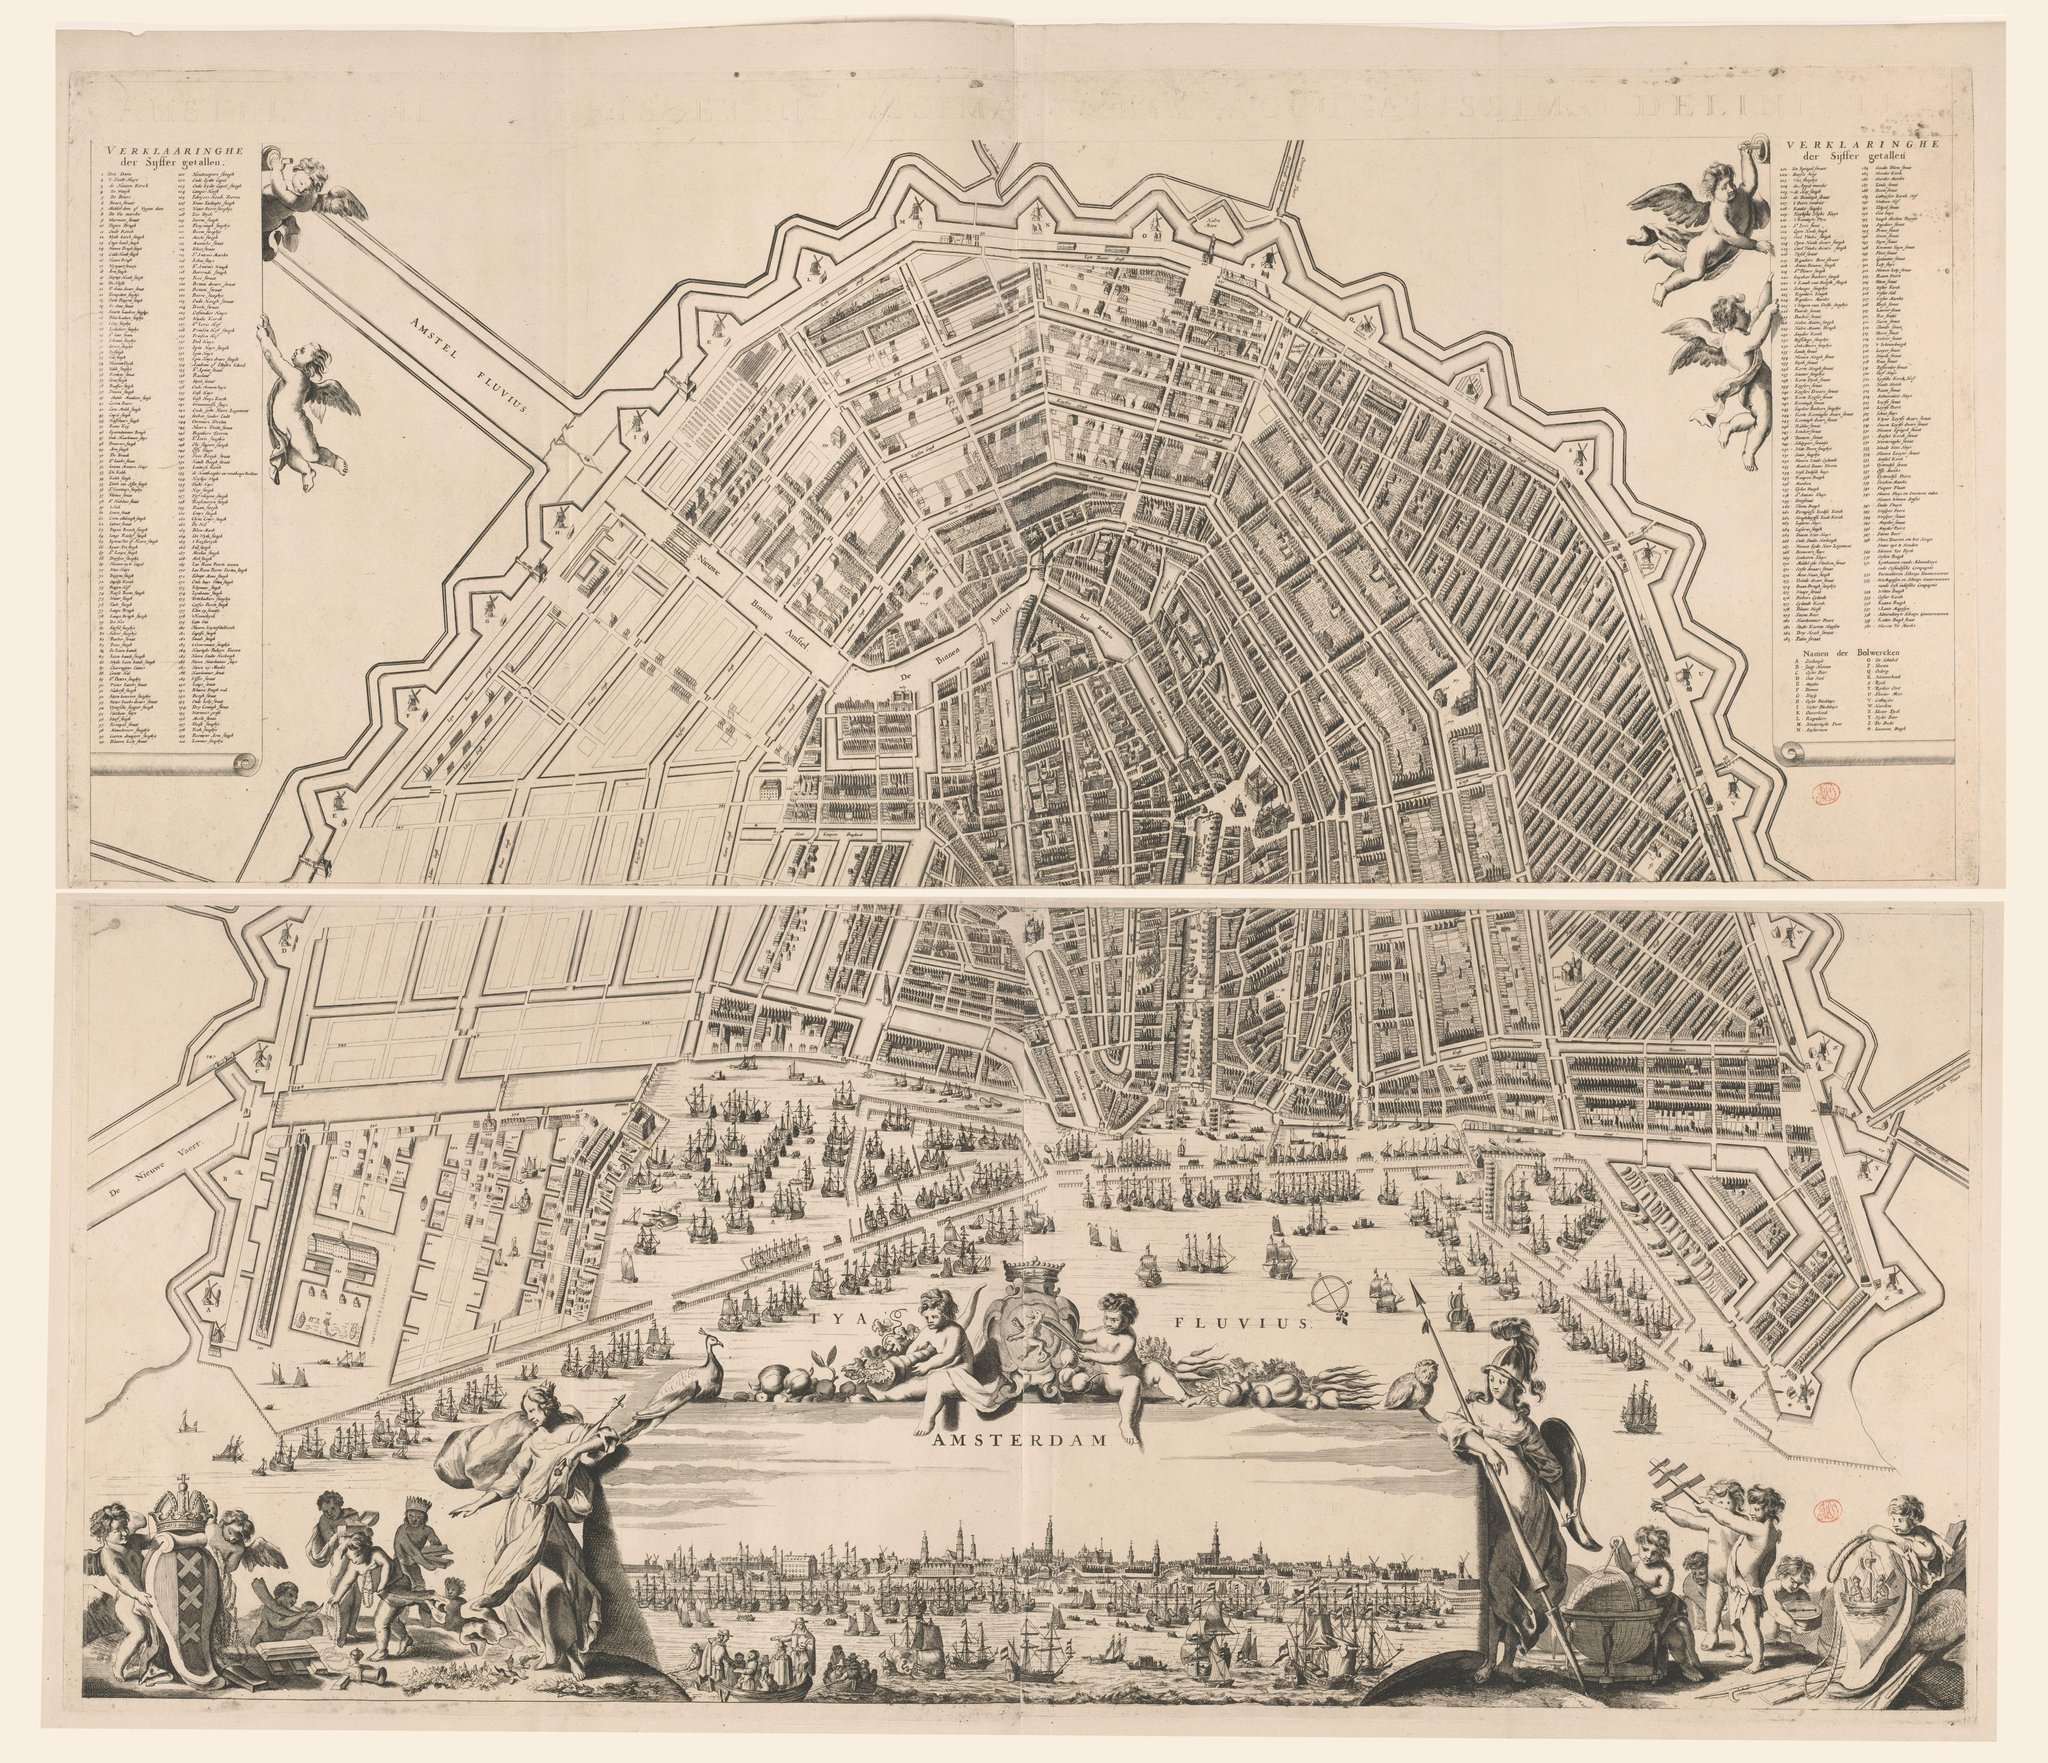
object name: print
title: Plattegrond van Amsterdam met stadsgezicht, bestaande uit twee delen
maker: Anonymous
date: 1676-1699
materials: paper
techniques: engraving, etching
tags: coat of arms (as symbol of the state, etc.) (+ city; municipal), (story of) juno (hera), (story of) minerva (pallas, athena), seal (as symbol of the state, etc.) (+ city; municipal), attributes of minerva: owl, globe, maps of cities, continents represented allegorically, trade, commerce and finance, position-finding at sea; nautical instruments, coat of arms (as symbol of the state, etc.) (+ province; provincial), prospect of city, town panorama, silhouette of city, amsterdam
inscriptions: collector's mark: Lugt 2228, collector's mark: Lugt 195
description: Plattegrond in vogelvluchtperspectief. Linksboven de legenda 1-200. Rechtsboven de legenda 201-360 en de legenda van de bolwerken A-Z. Linksonder putti met het wapen van de stad en kinderen met rijkdommen uit verschillende werelddelen. Onder in het midden een gezicht op de stad geflankeerd door Juno (links) en Minerva (rechts). Boven dit gezicht twee kinderen met het wapen van Holland. Rechtsonder kinderen met het stadszegel en voorwerpen die verwijzen naar de zeevaart. Oriëntatie: zuidzuidwest boven.